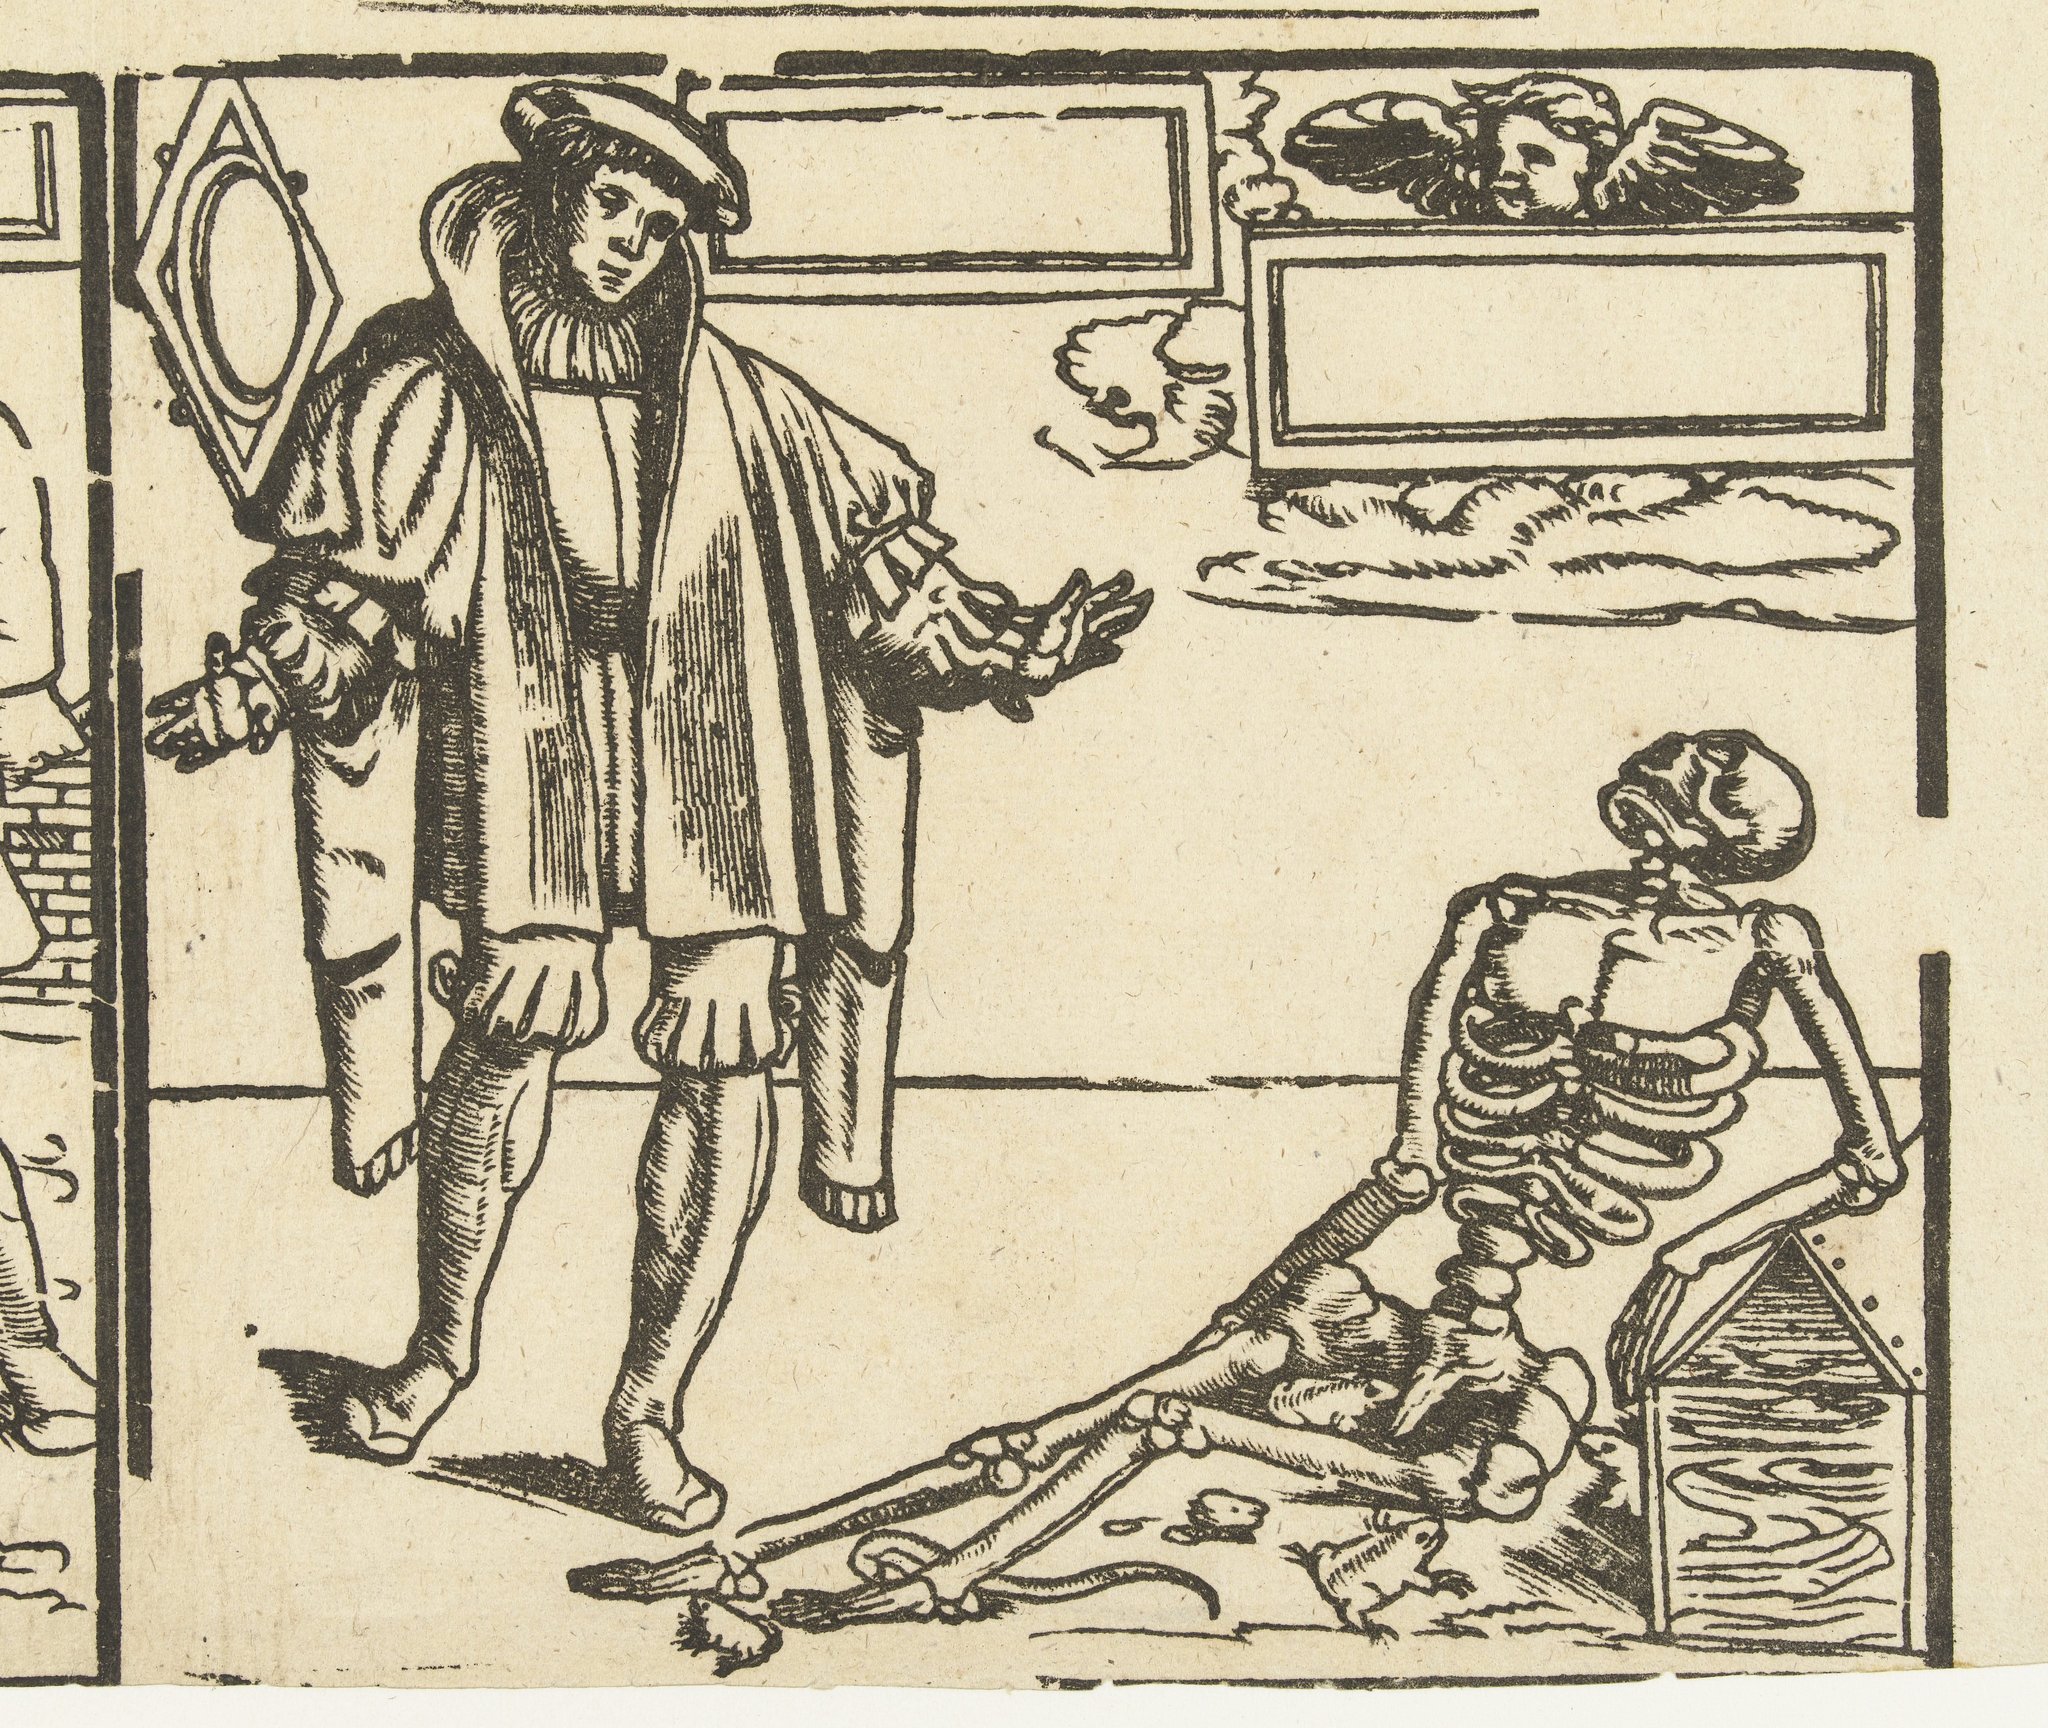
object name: print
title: Man met de Dood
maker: Anonymous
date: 1550-1600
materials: paper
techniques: woodcut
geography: low countries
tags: tailless amphibians: toad, death as skeleton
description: Gedrukt rechtsonder op blad met drie andere voorstellingen. Een man en een skelet leunend op een doodskist, padden en slang bij zich.